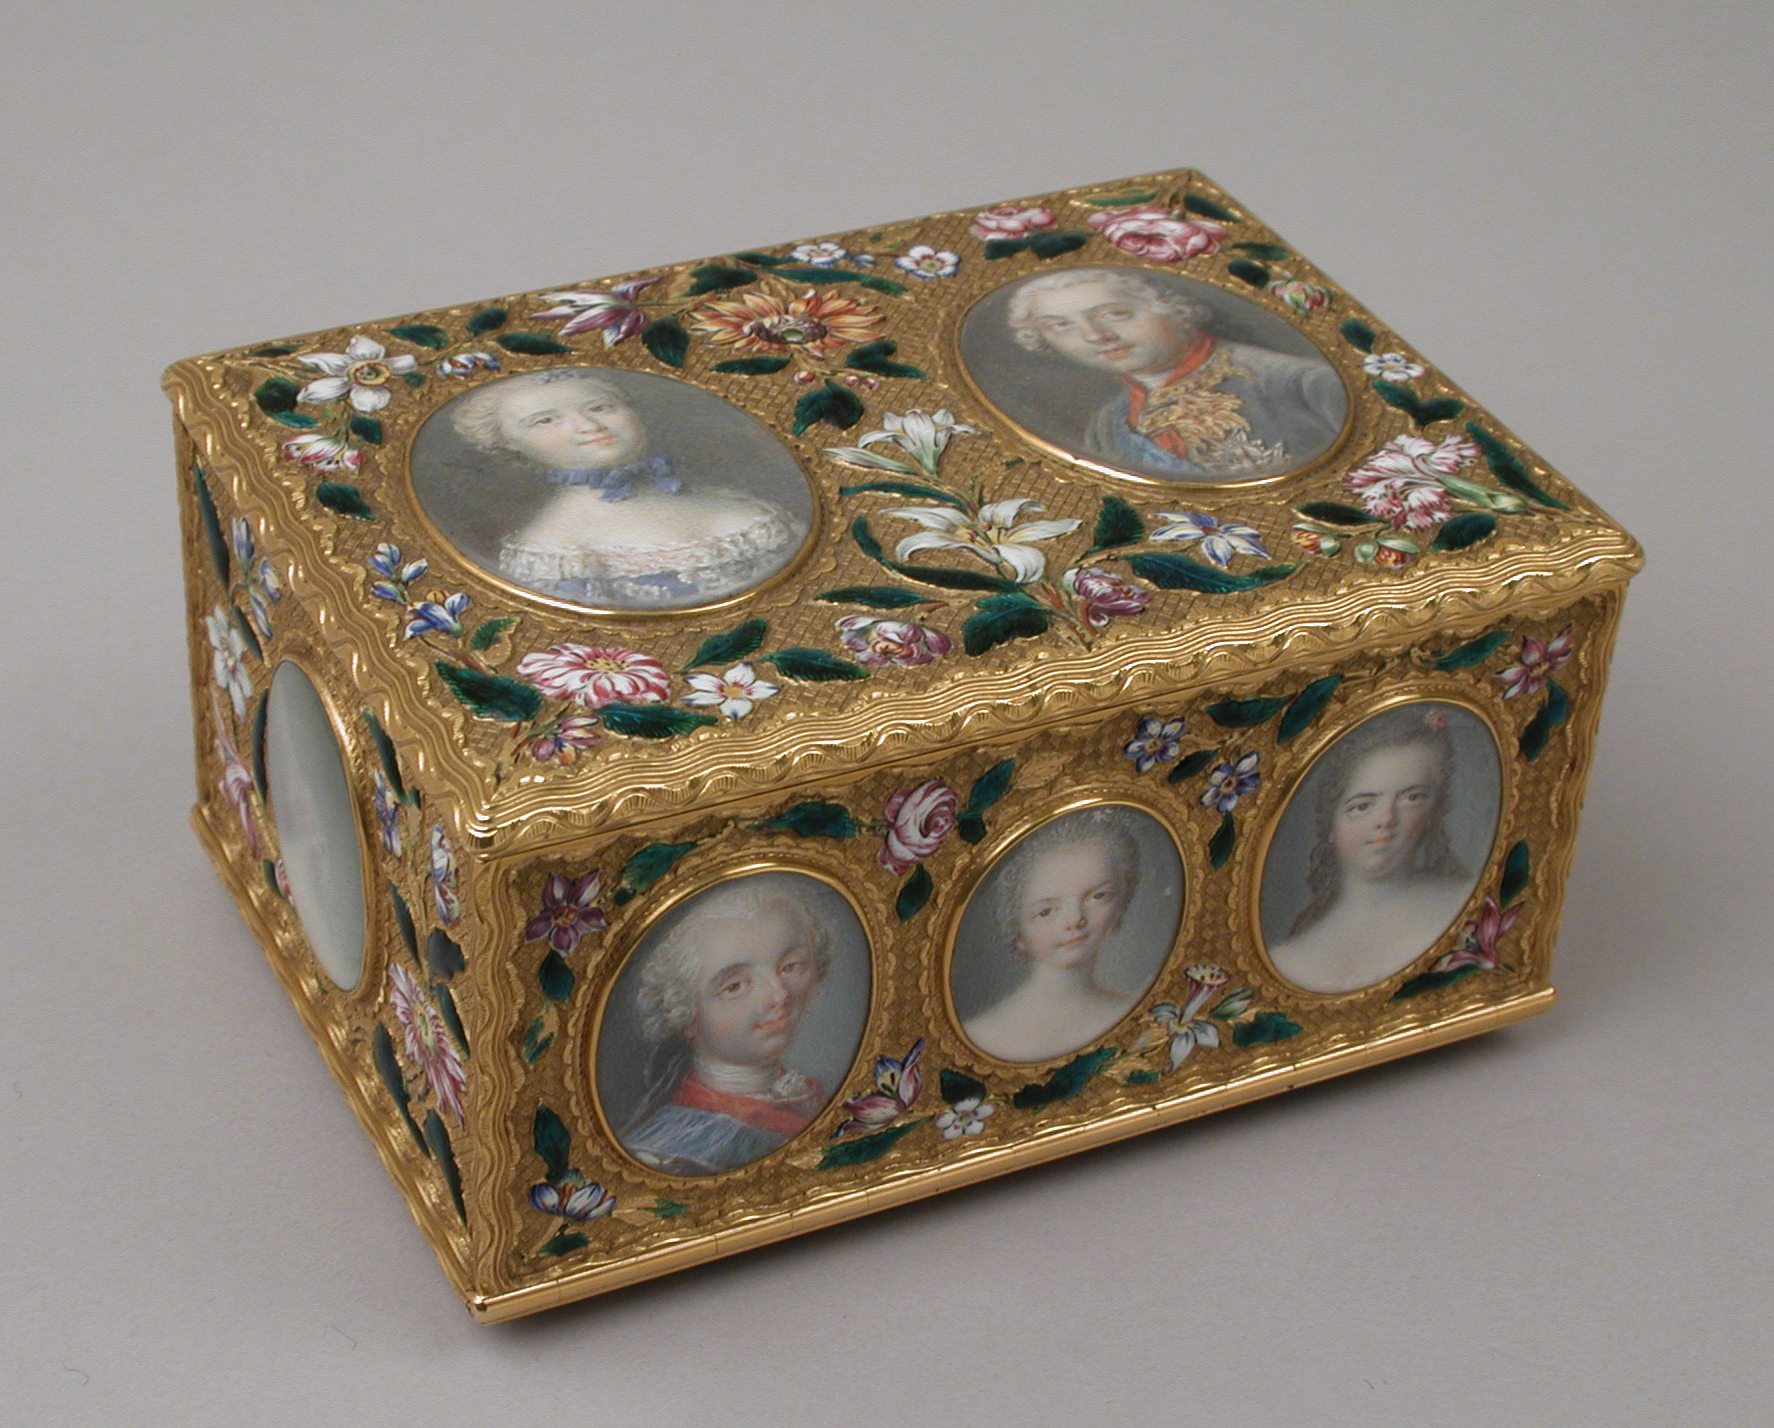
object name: snuffbox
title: Double snuffbox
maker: jean ducrollay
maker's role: maker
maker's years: 1709-1760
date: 1749-1750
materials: enamel, glass, gold, gouache, parchment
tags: girls,men,portraits,women